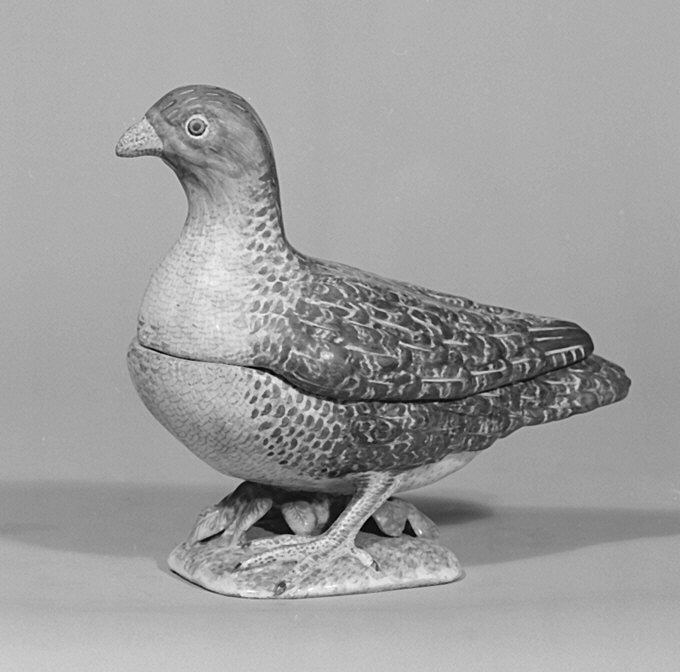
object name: tureen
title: Tureen in the form of a partridge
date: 1750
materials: faience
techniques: glazing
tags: birds